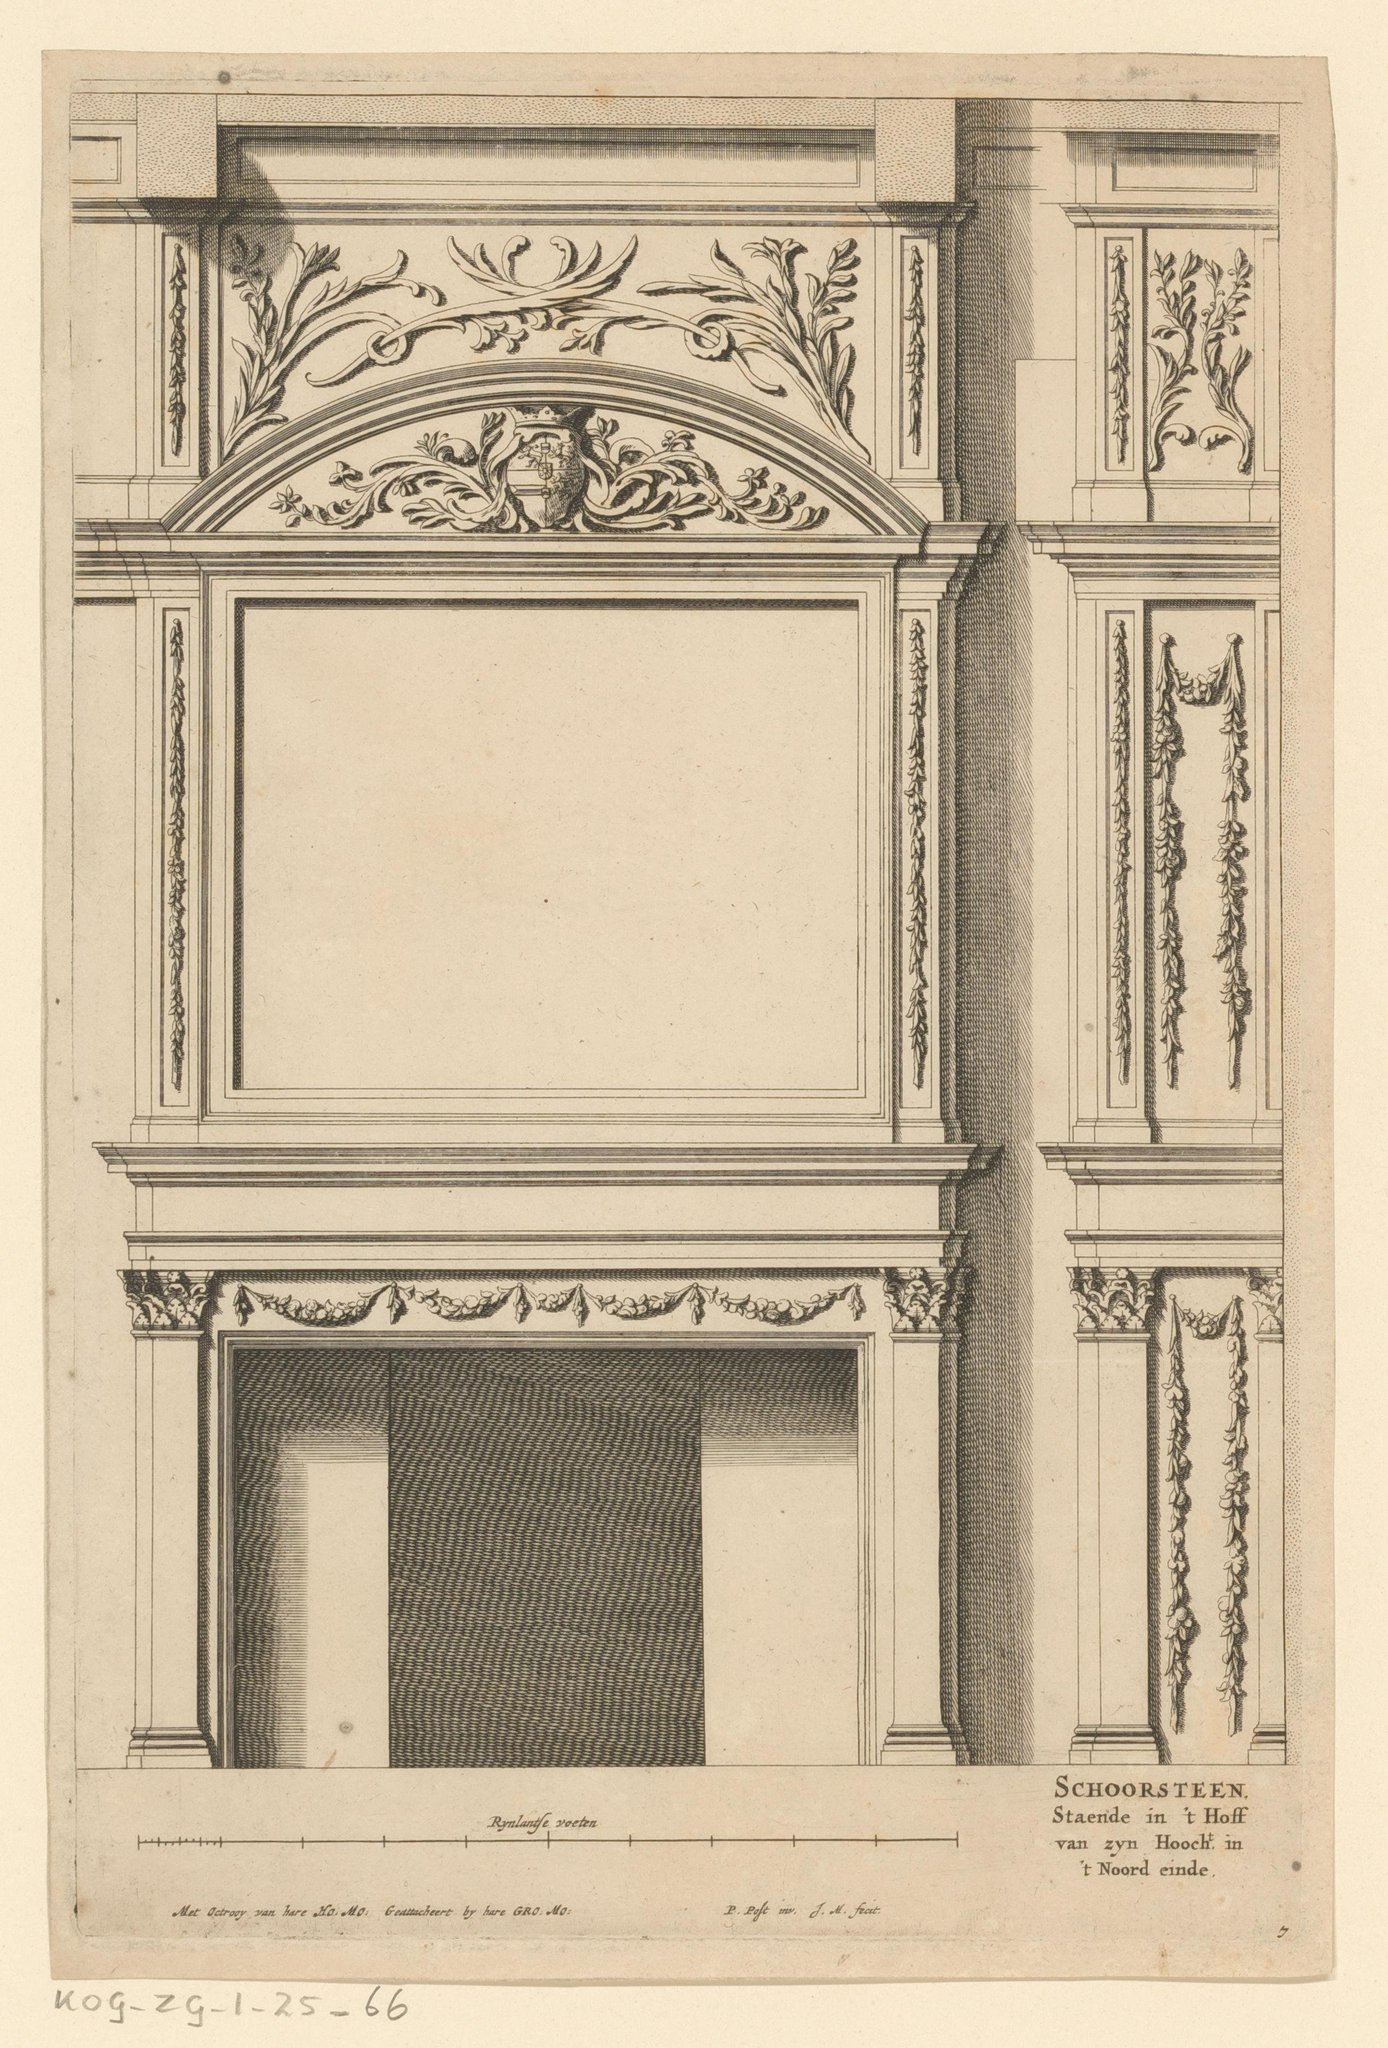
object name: print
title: Schoorsteen Staende in 't Hoff van zijn Hoocht. in 't Noord einde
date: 1669-1706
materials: paper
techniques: engraving, etching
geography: amsterdam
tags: chimney, chimney ornaments, chimney-piece, mantelpiece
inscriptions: stamp:, : ‘Met Octrooy van hare HO: MO: Geattacheert bij hare GRO: MO:’, stamp:, collector's mark: Lugt 1641a, stamp:, collector's mark: Lugt 1641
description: Titelprent is onderdeel van een serie bestaande uit een titelprent en 22 vervolg prenten. De serie is voor het eerst uitgegeven door Pieter Jansz. Post in Den Haag of Rotterdam. De huidige (tweede staat) is uitgegeven door Frederik de Wit tussen 1669 en 1706. De volgorde van de prenten is in deze serie veranderd. De prenten zijn een derde keer uitgegeven door Pieter van der Aa in 1715 te Leiden. Hier is de volgorde wederom aangepast.